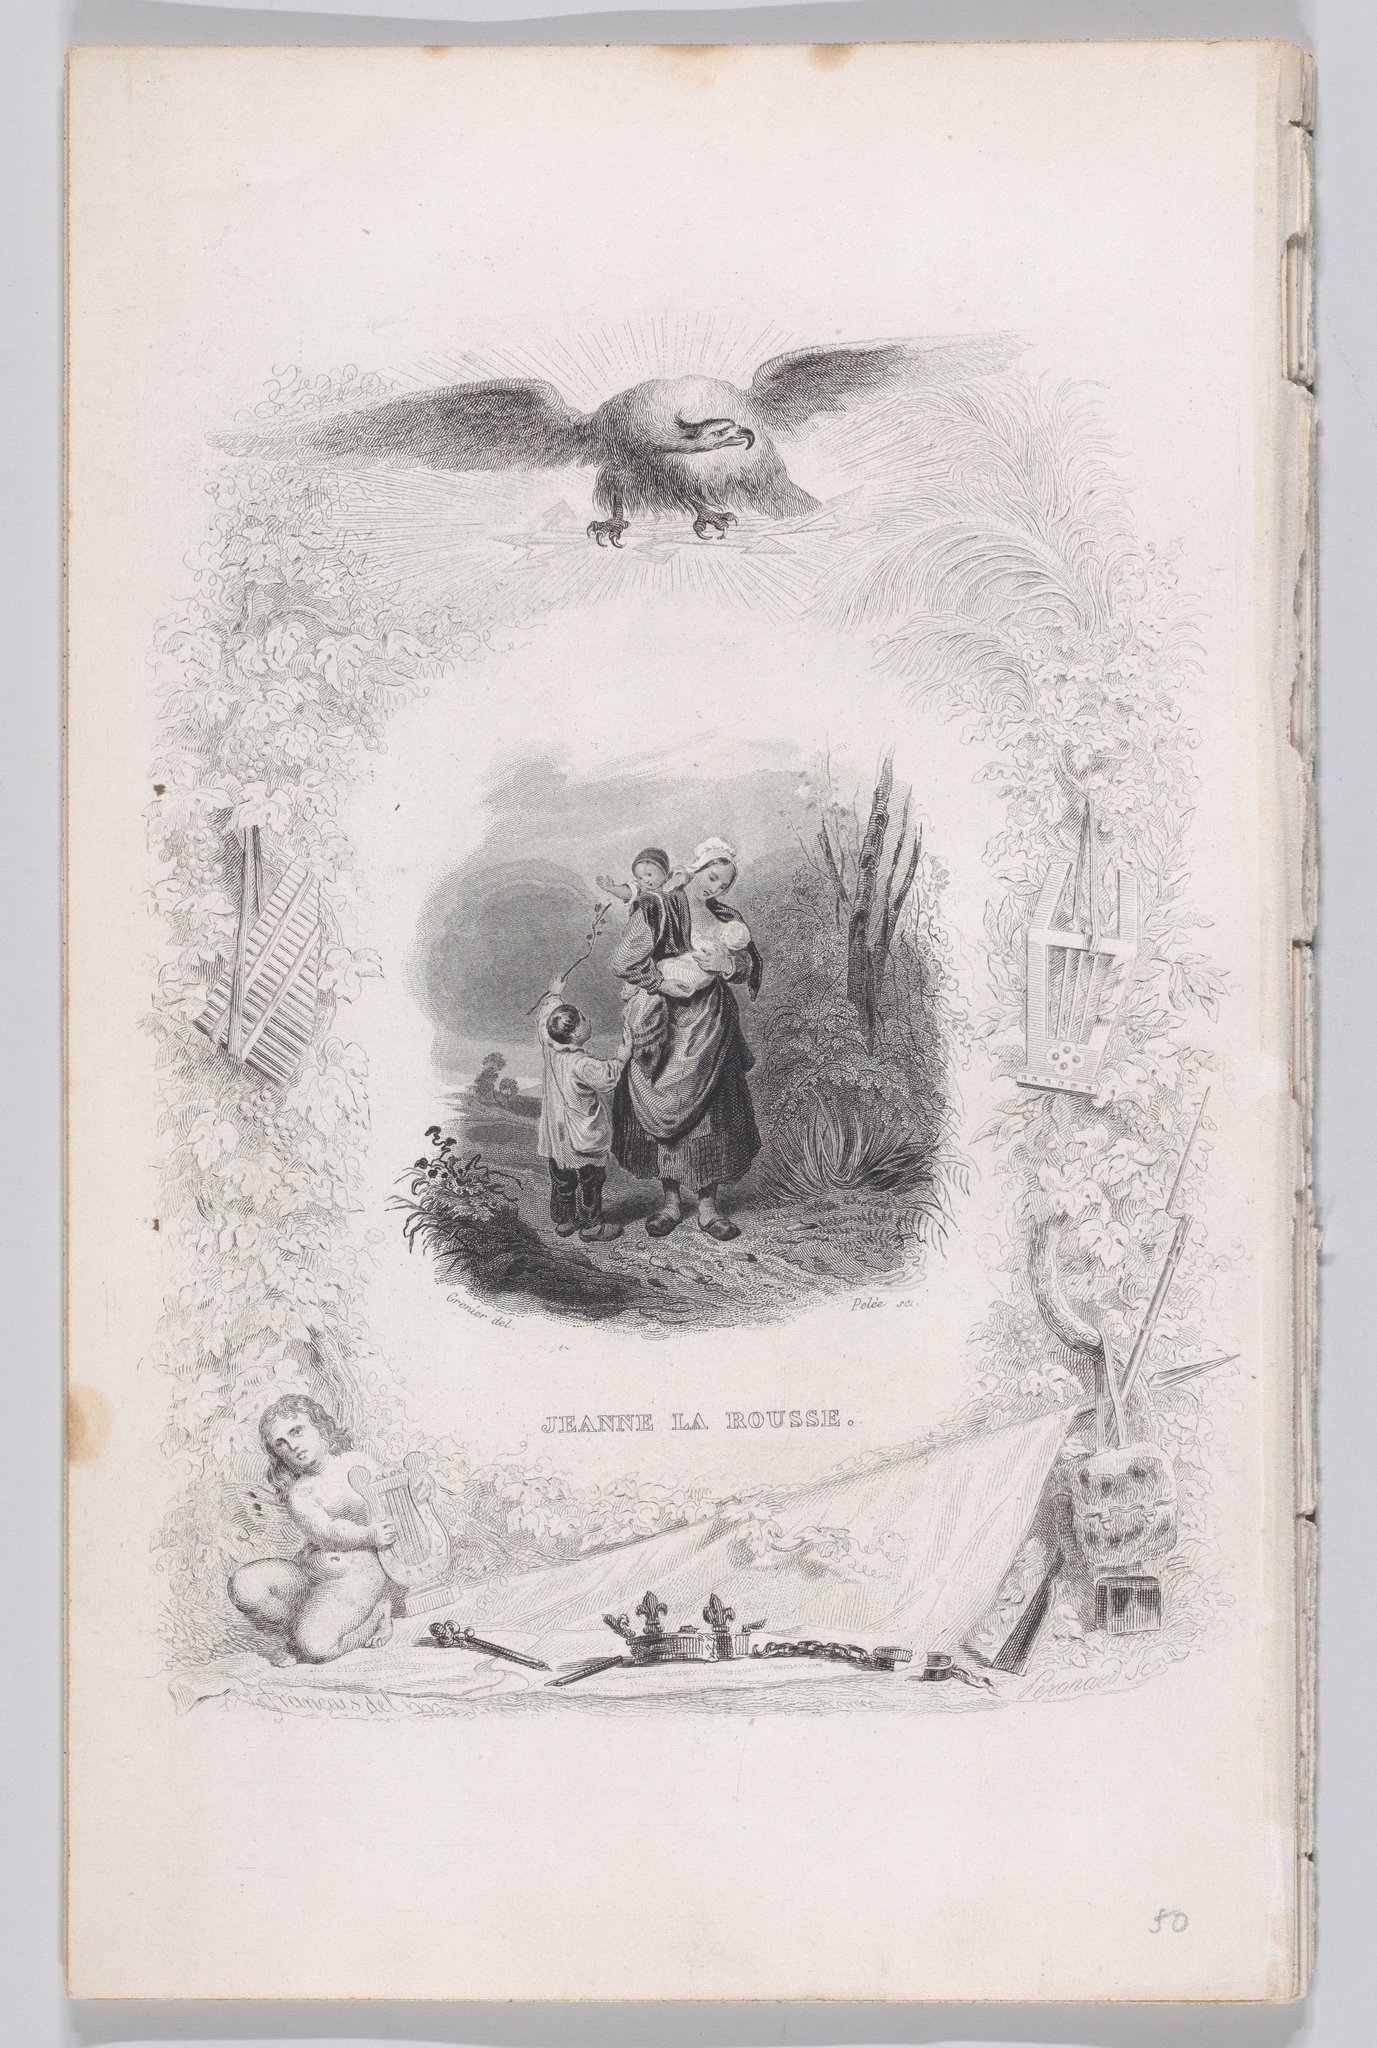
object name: print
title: Jeanne, the Redhead, from "The Songs of Béranger"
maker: françois-louis français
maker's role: designer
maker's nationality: french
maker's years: 1814-1897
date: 1829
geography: paris